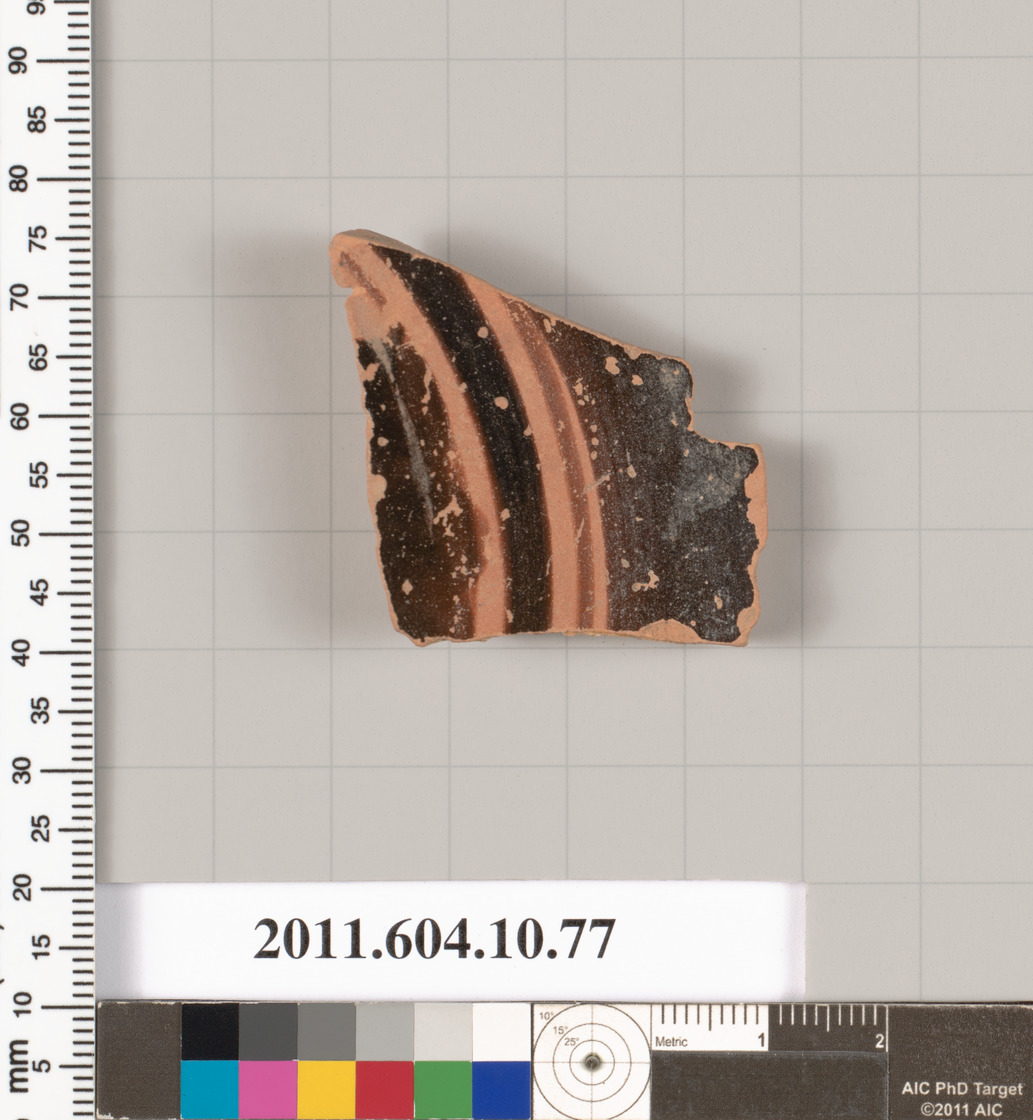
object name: fragment of a bowl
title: Terracotta fragment of a bowl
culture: etruscan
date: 400-301 BCE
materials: terracotta